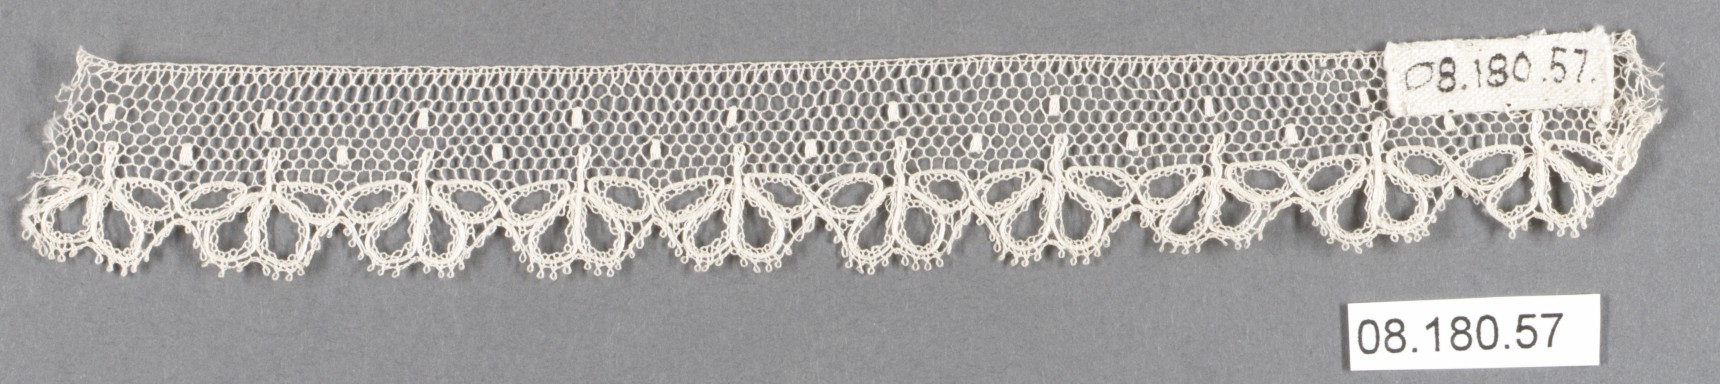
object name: baby lace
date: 1801-1900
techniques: lace